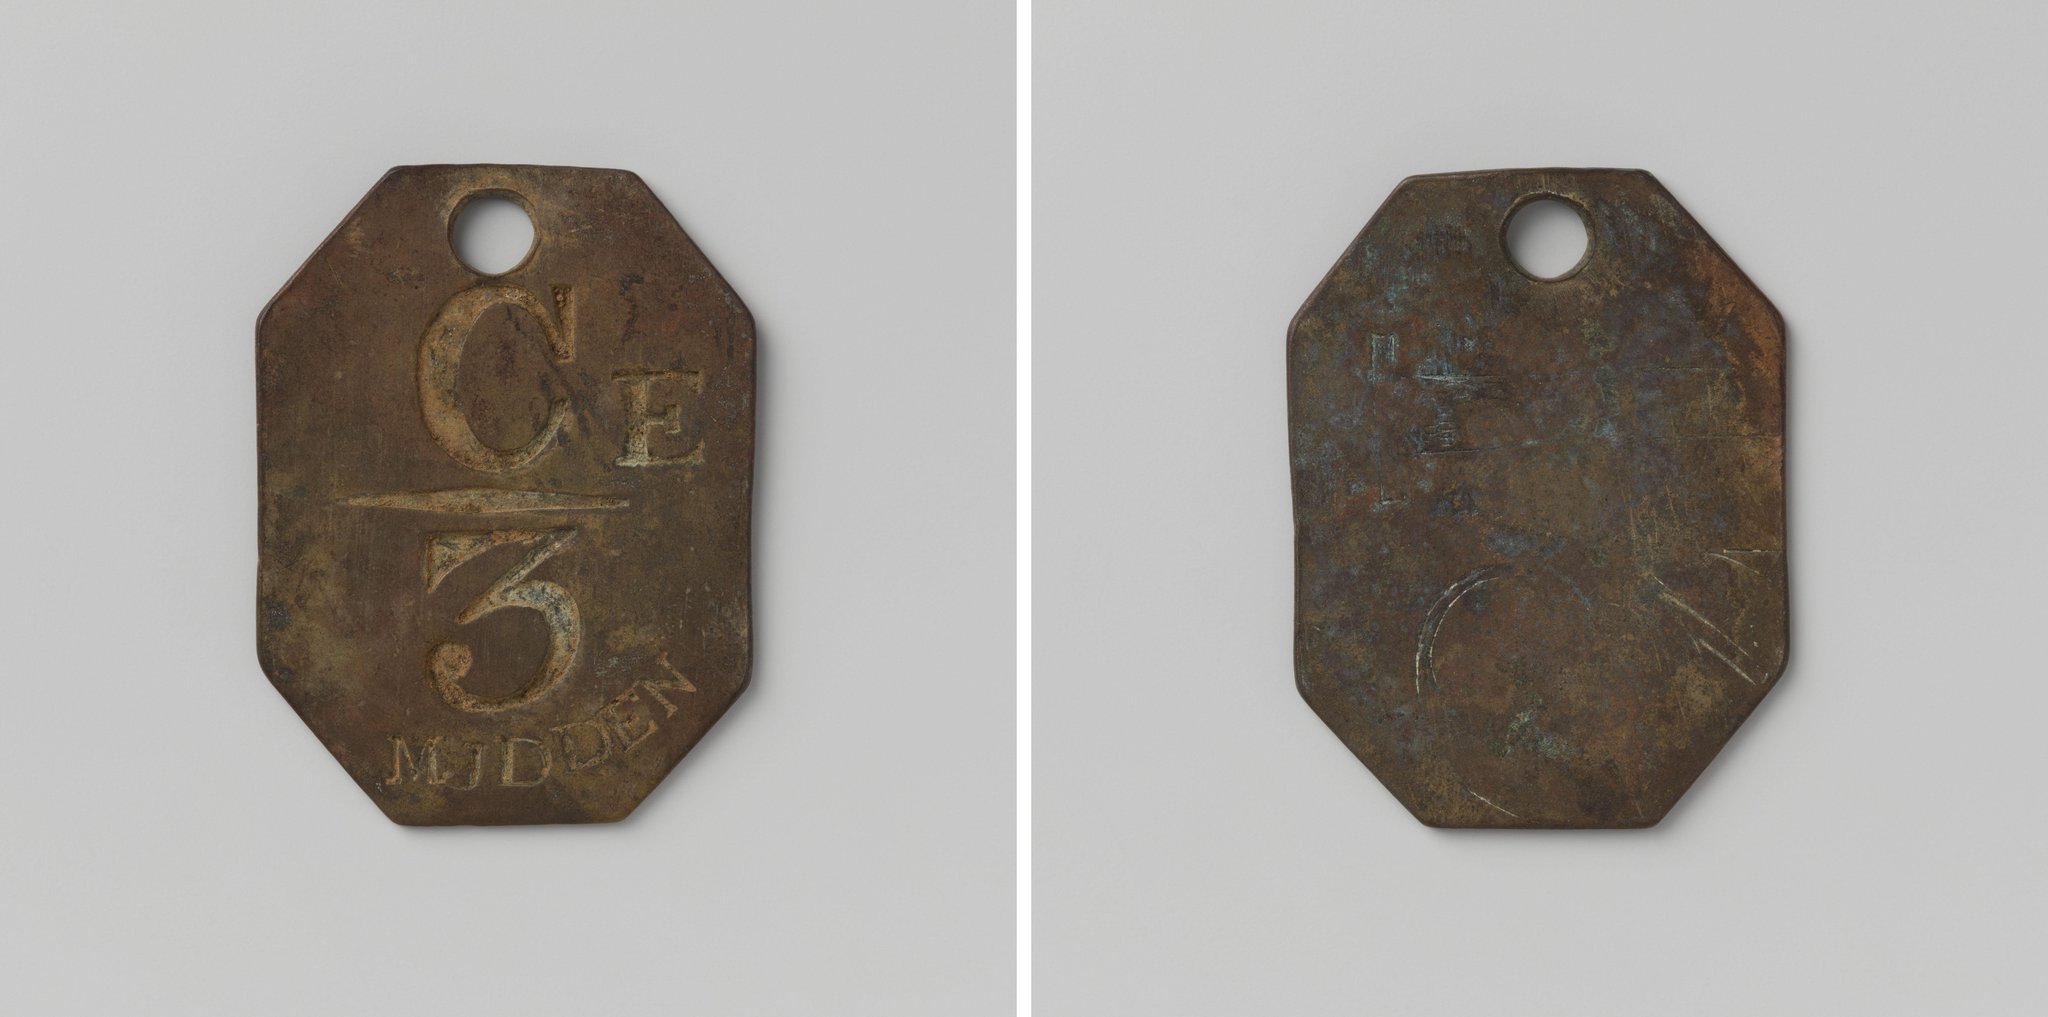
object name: plate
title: Plaat met opschrift Ce 3 midden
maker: Anonymous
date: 1650-1850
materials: copper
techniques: engraving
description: achthoekige penning met gat erin. Voorzijde: opschrift Ce boven cijfer 3 en opschrift "midden". Keerzijde: onduidelijke gravure